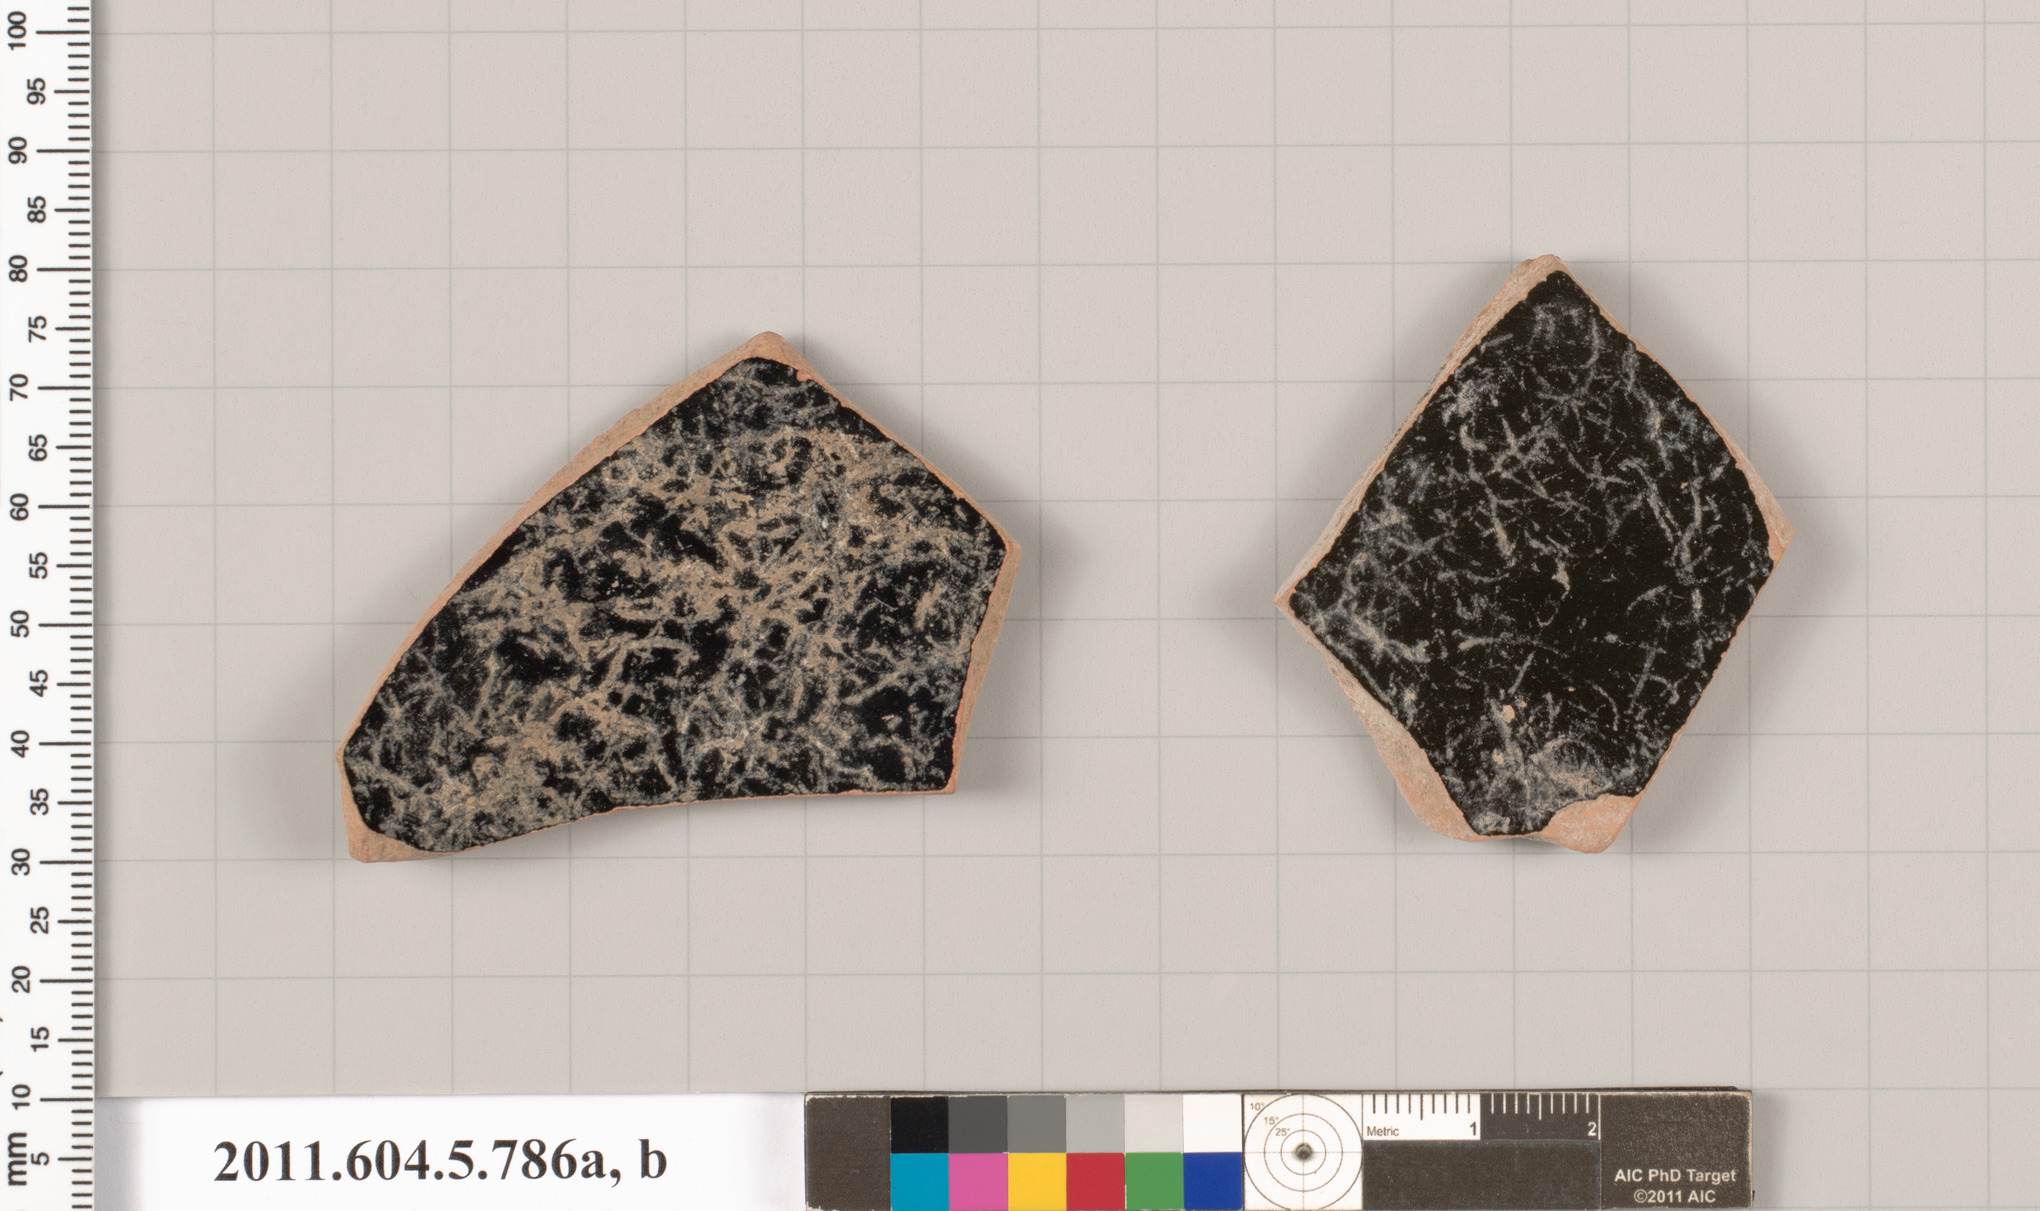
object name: kylix fragment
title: Terracotta fragments of kylikes (drinking cups)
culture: greek, attic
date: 600-401 BCE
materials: terracotta